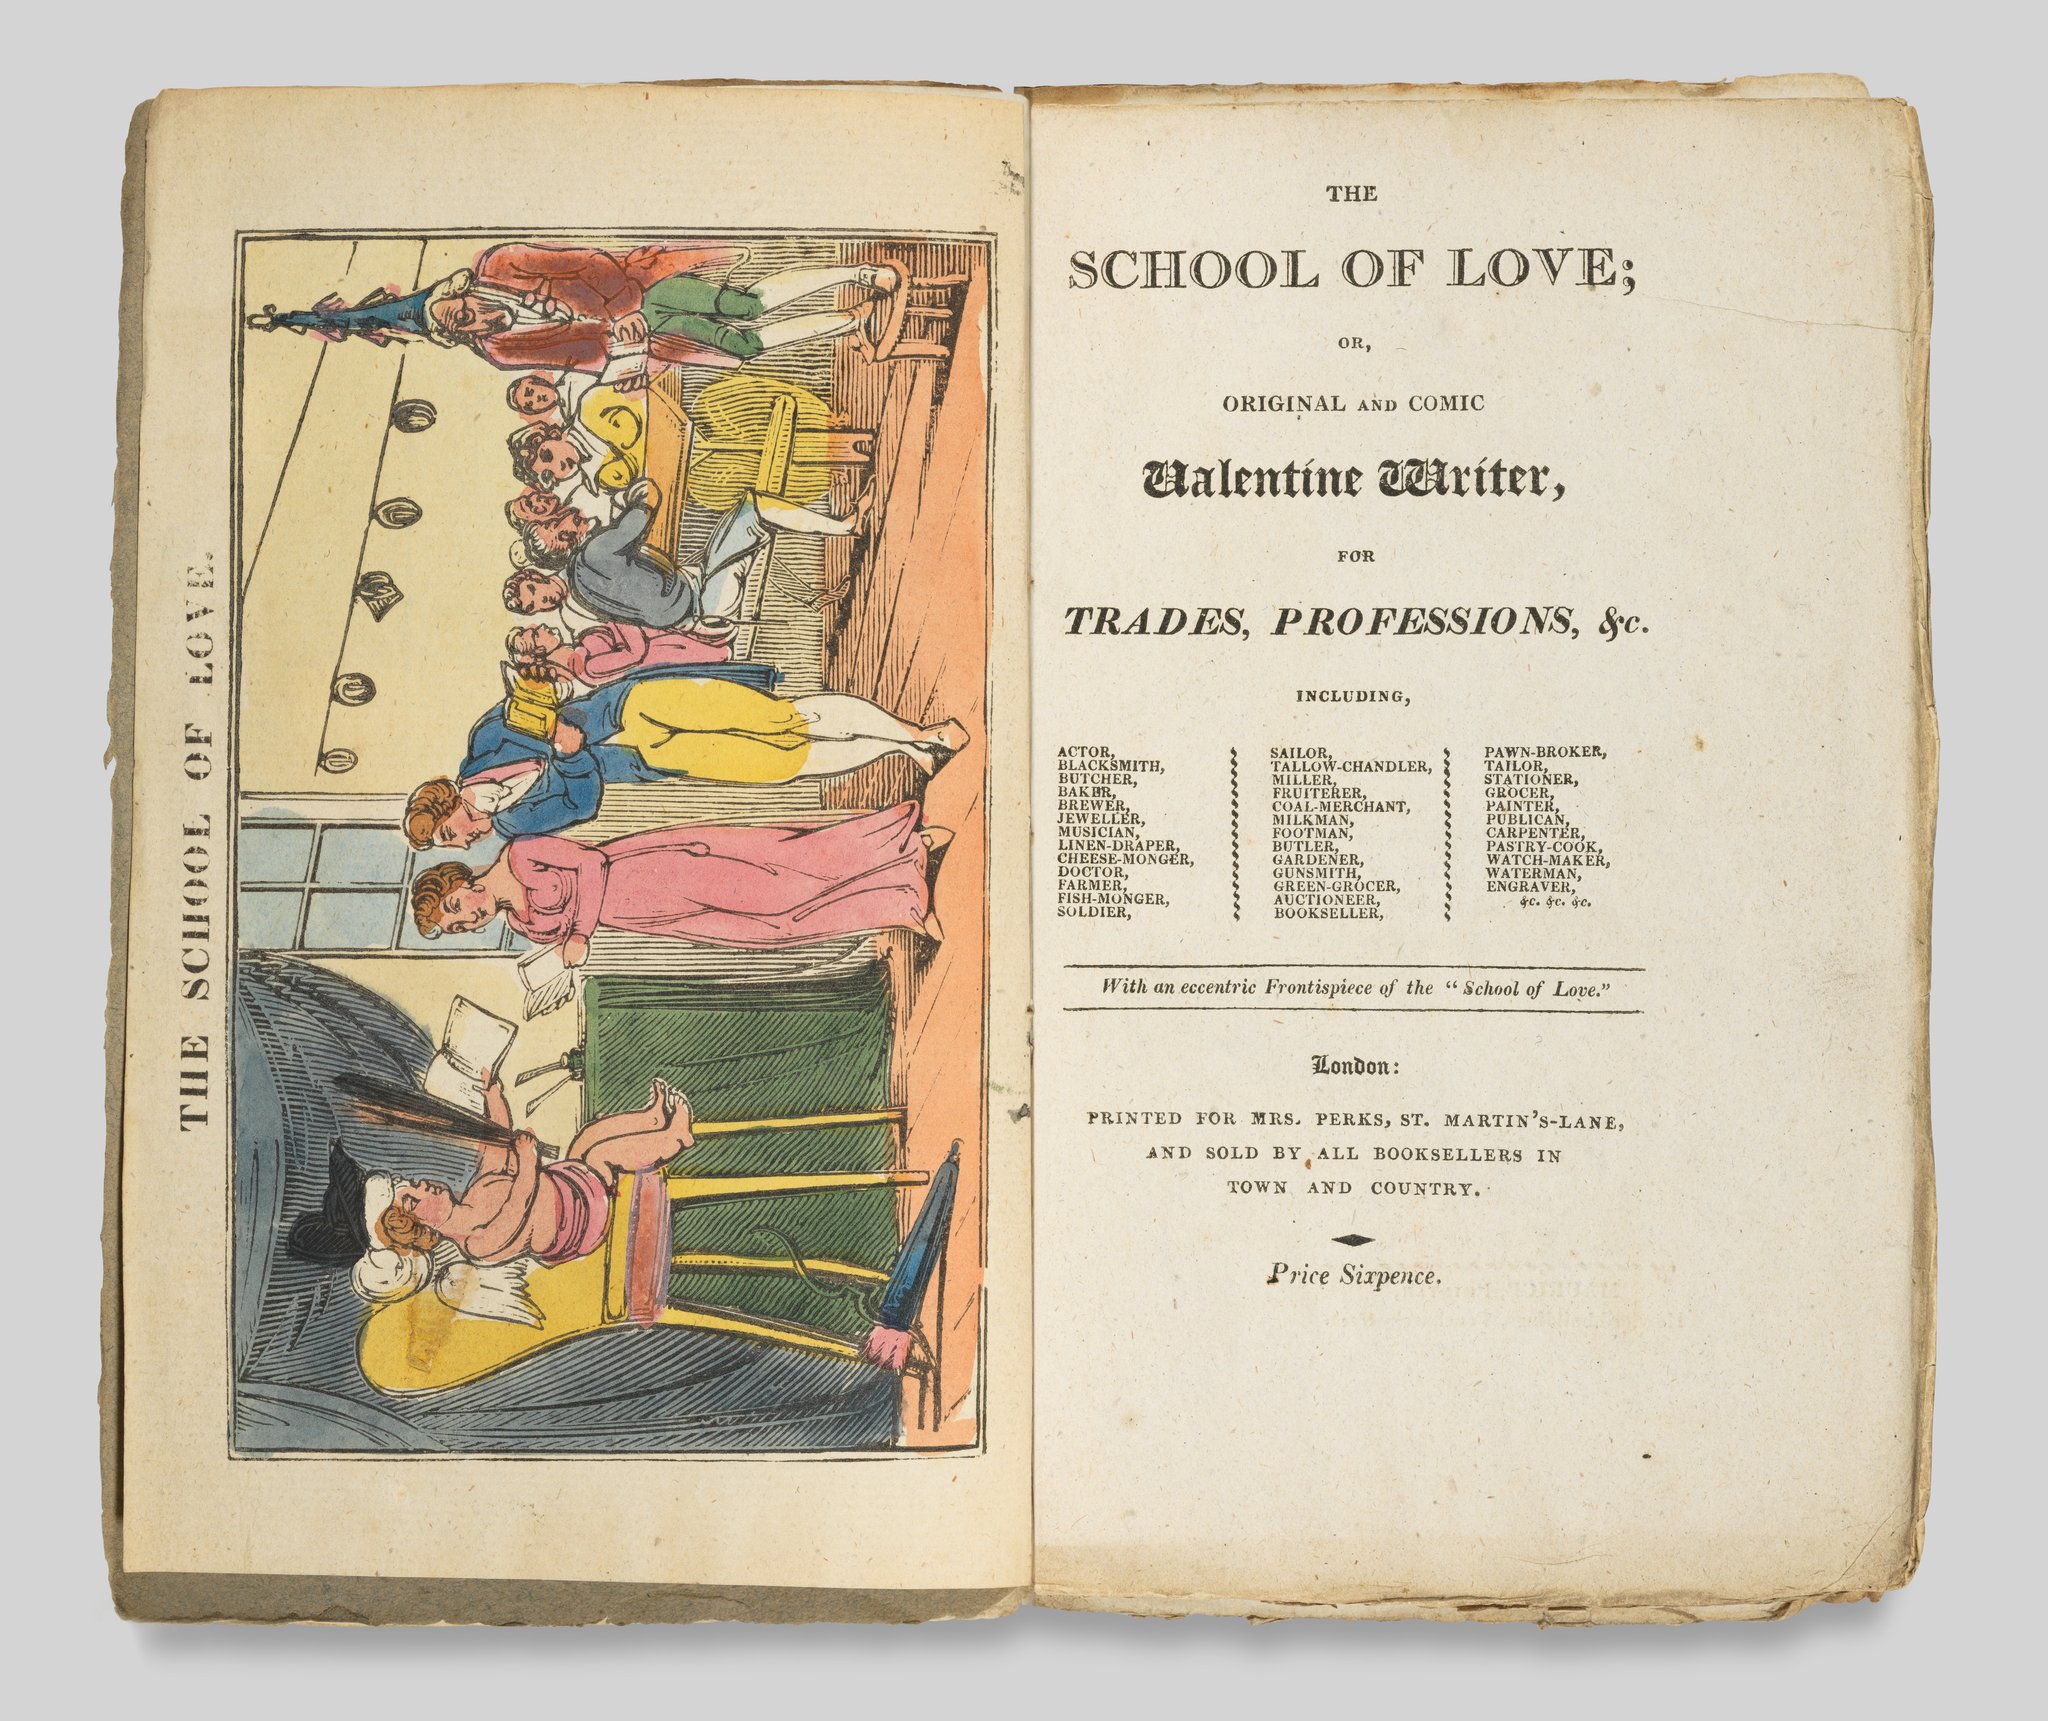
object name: book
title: The School of Love; or, Original and Comic Valentine Writer, for Trades, Professions, &c.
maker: mrs. perks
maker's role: publisher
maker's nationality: british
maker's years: 1800-1900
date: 1814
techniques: hand coloring, engraving